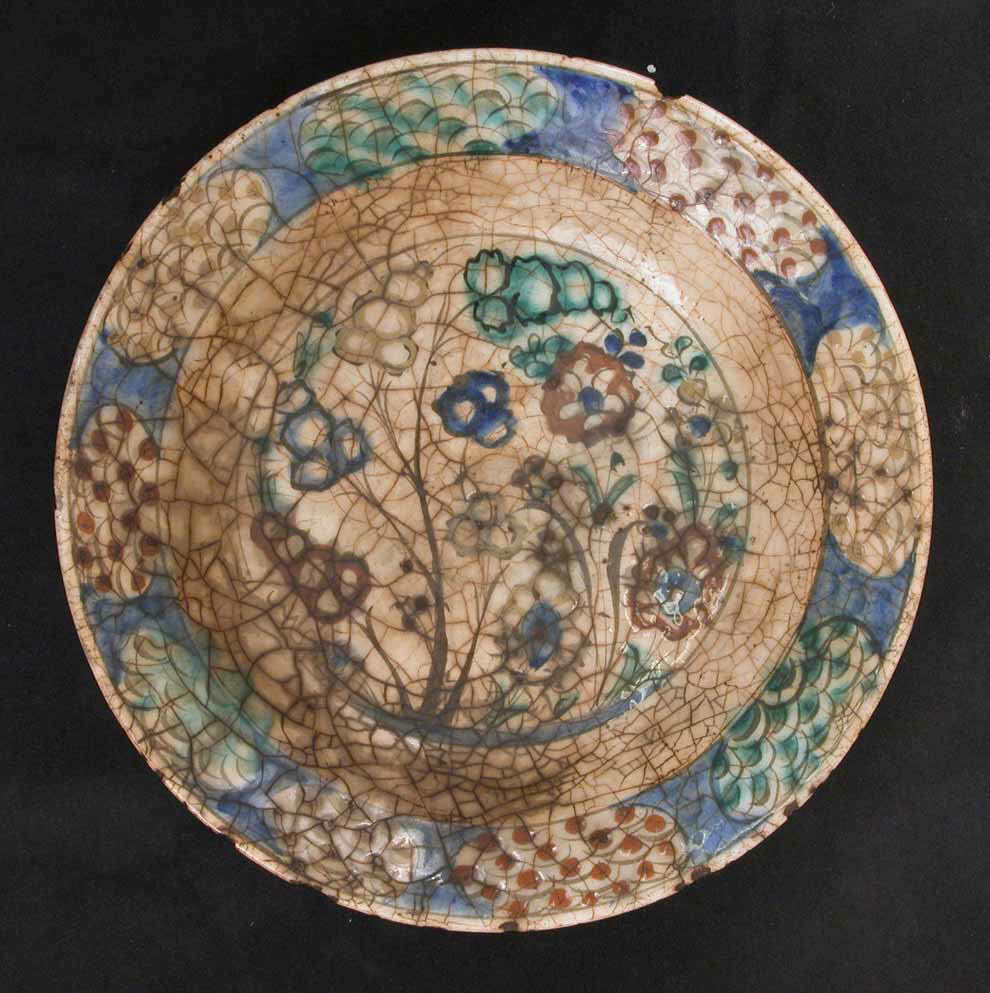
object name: dish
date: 1601-1700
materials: stonepaste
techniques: painting, underglaze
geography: iran